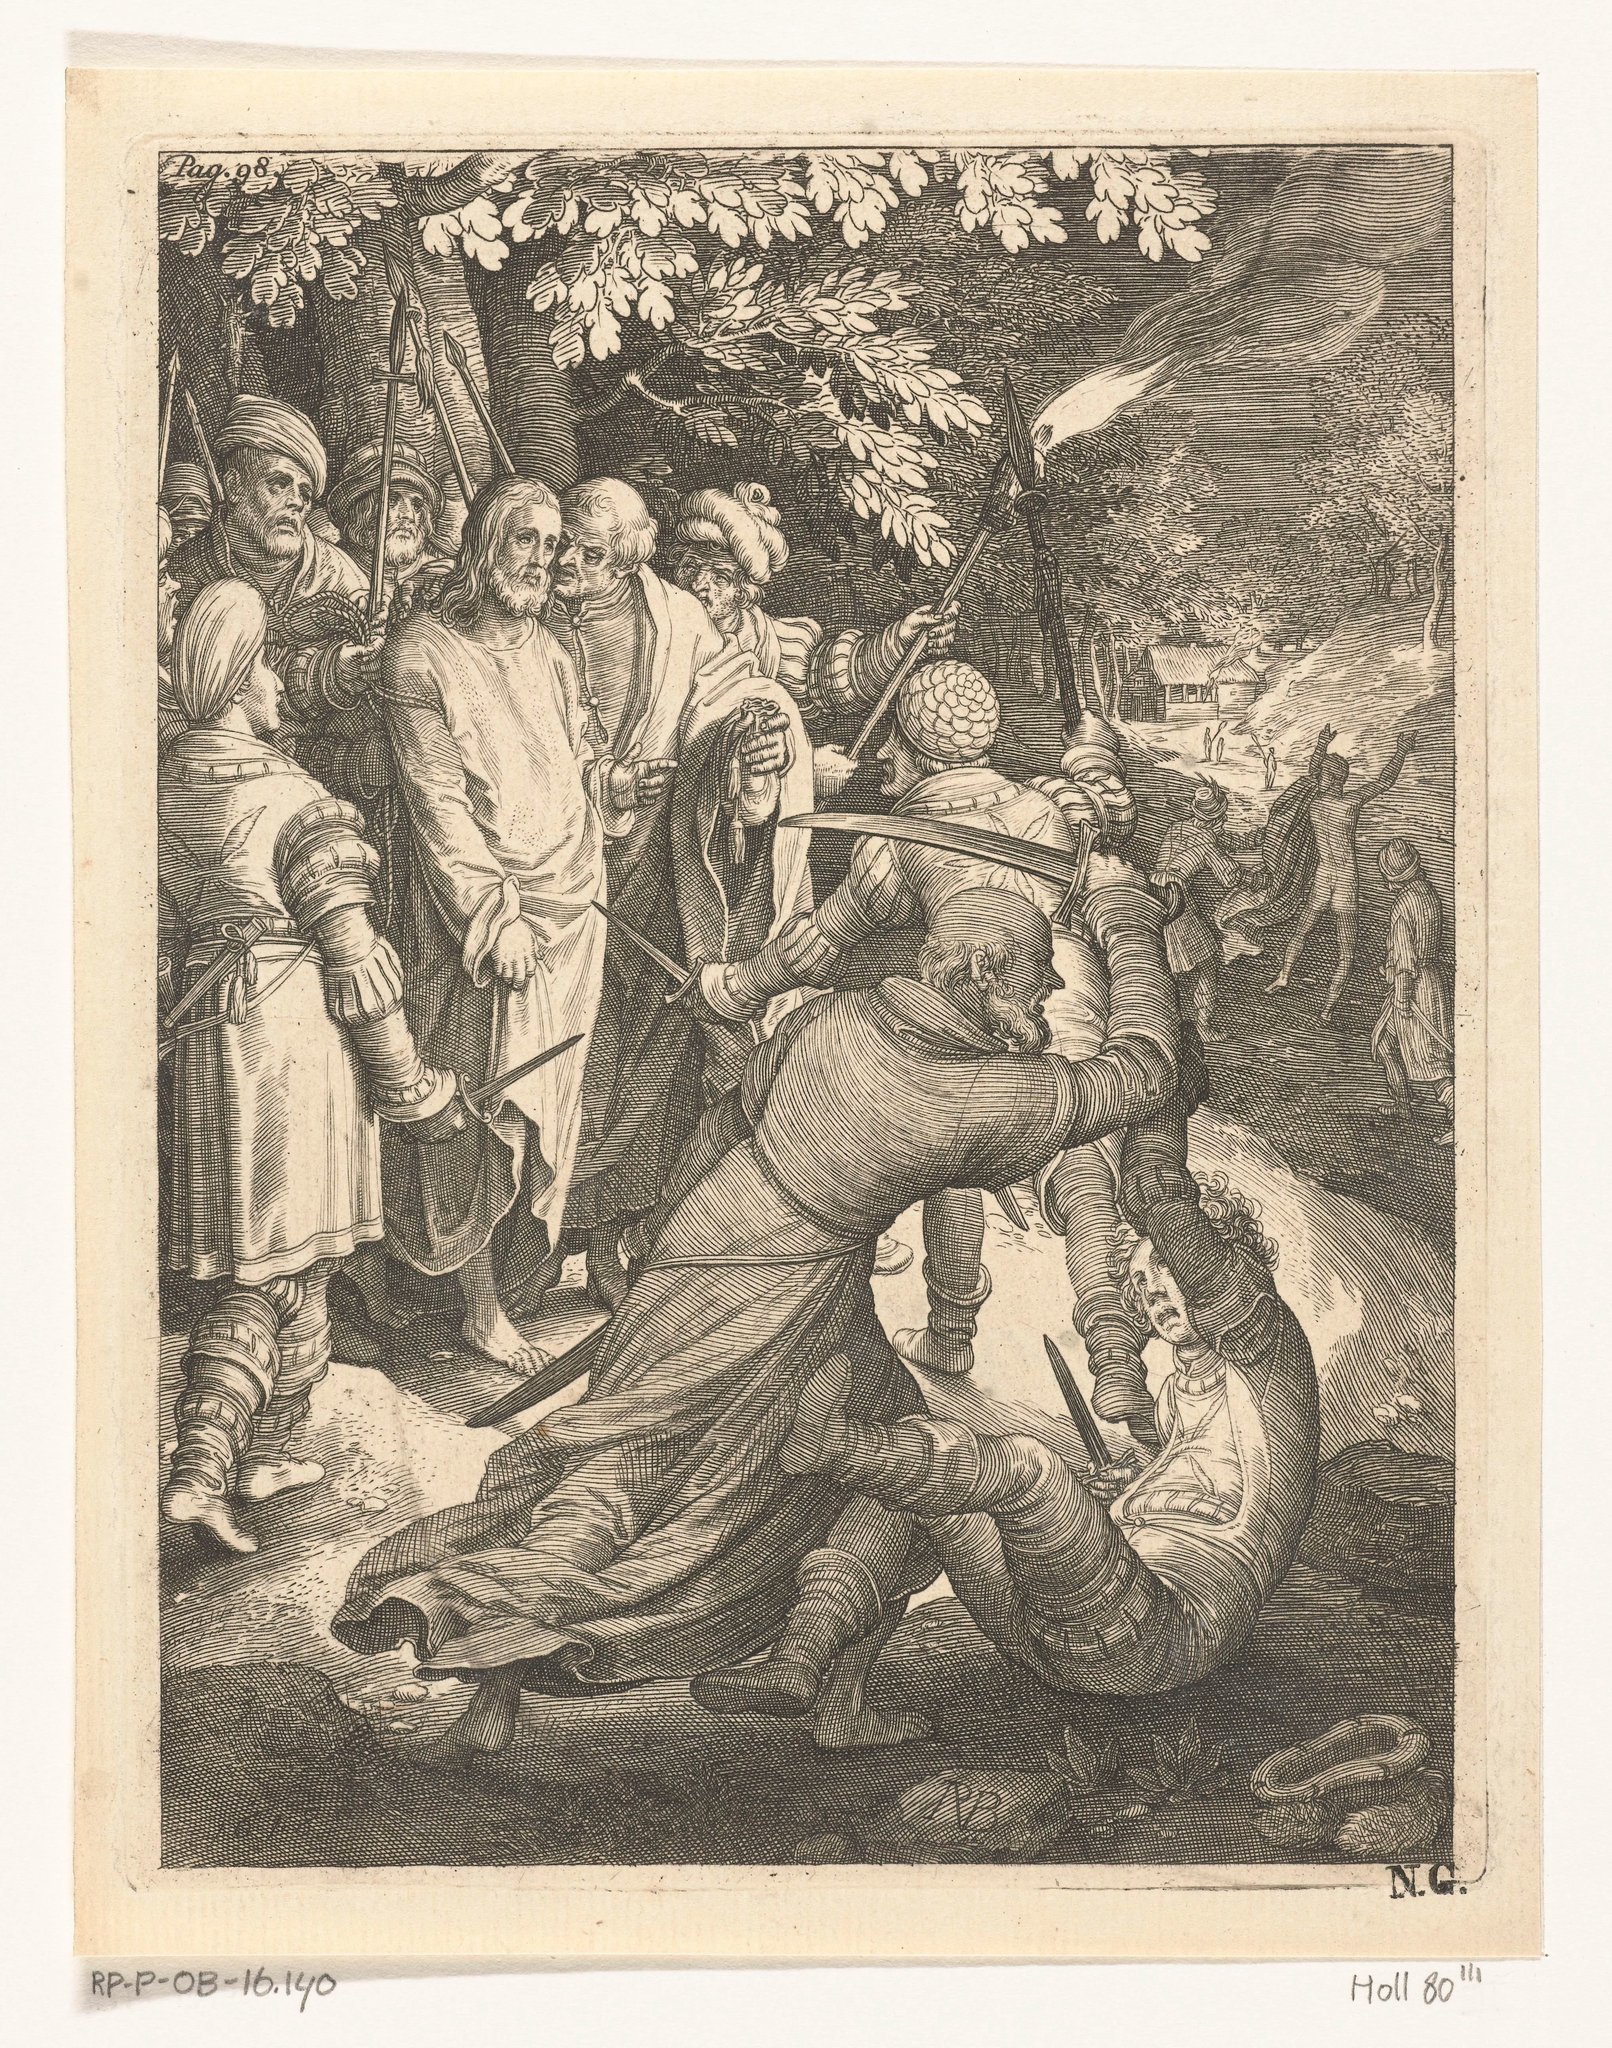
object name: print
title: Gevangenneming van Christus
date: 1618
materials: paper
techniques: engraving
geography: netherlands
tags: the arrest of christ ~ garden of gethsemane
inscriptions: collector's mark: Lugt 1967, collector's mark: Lugt 2228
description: Christus wordt gevangen genomen door soldaten als Judas hem met een kus verraadt. Op de voorgrond heft Simon Petrus zijn zwaard om het oor af te hakken van de slaaf van de hogepriester.